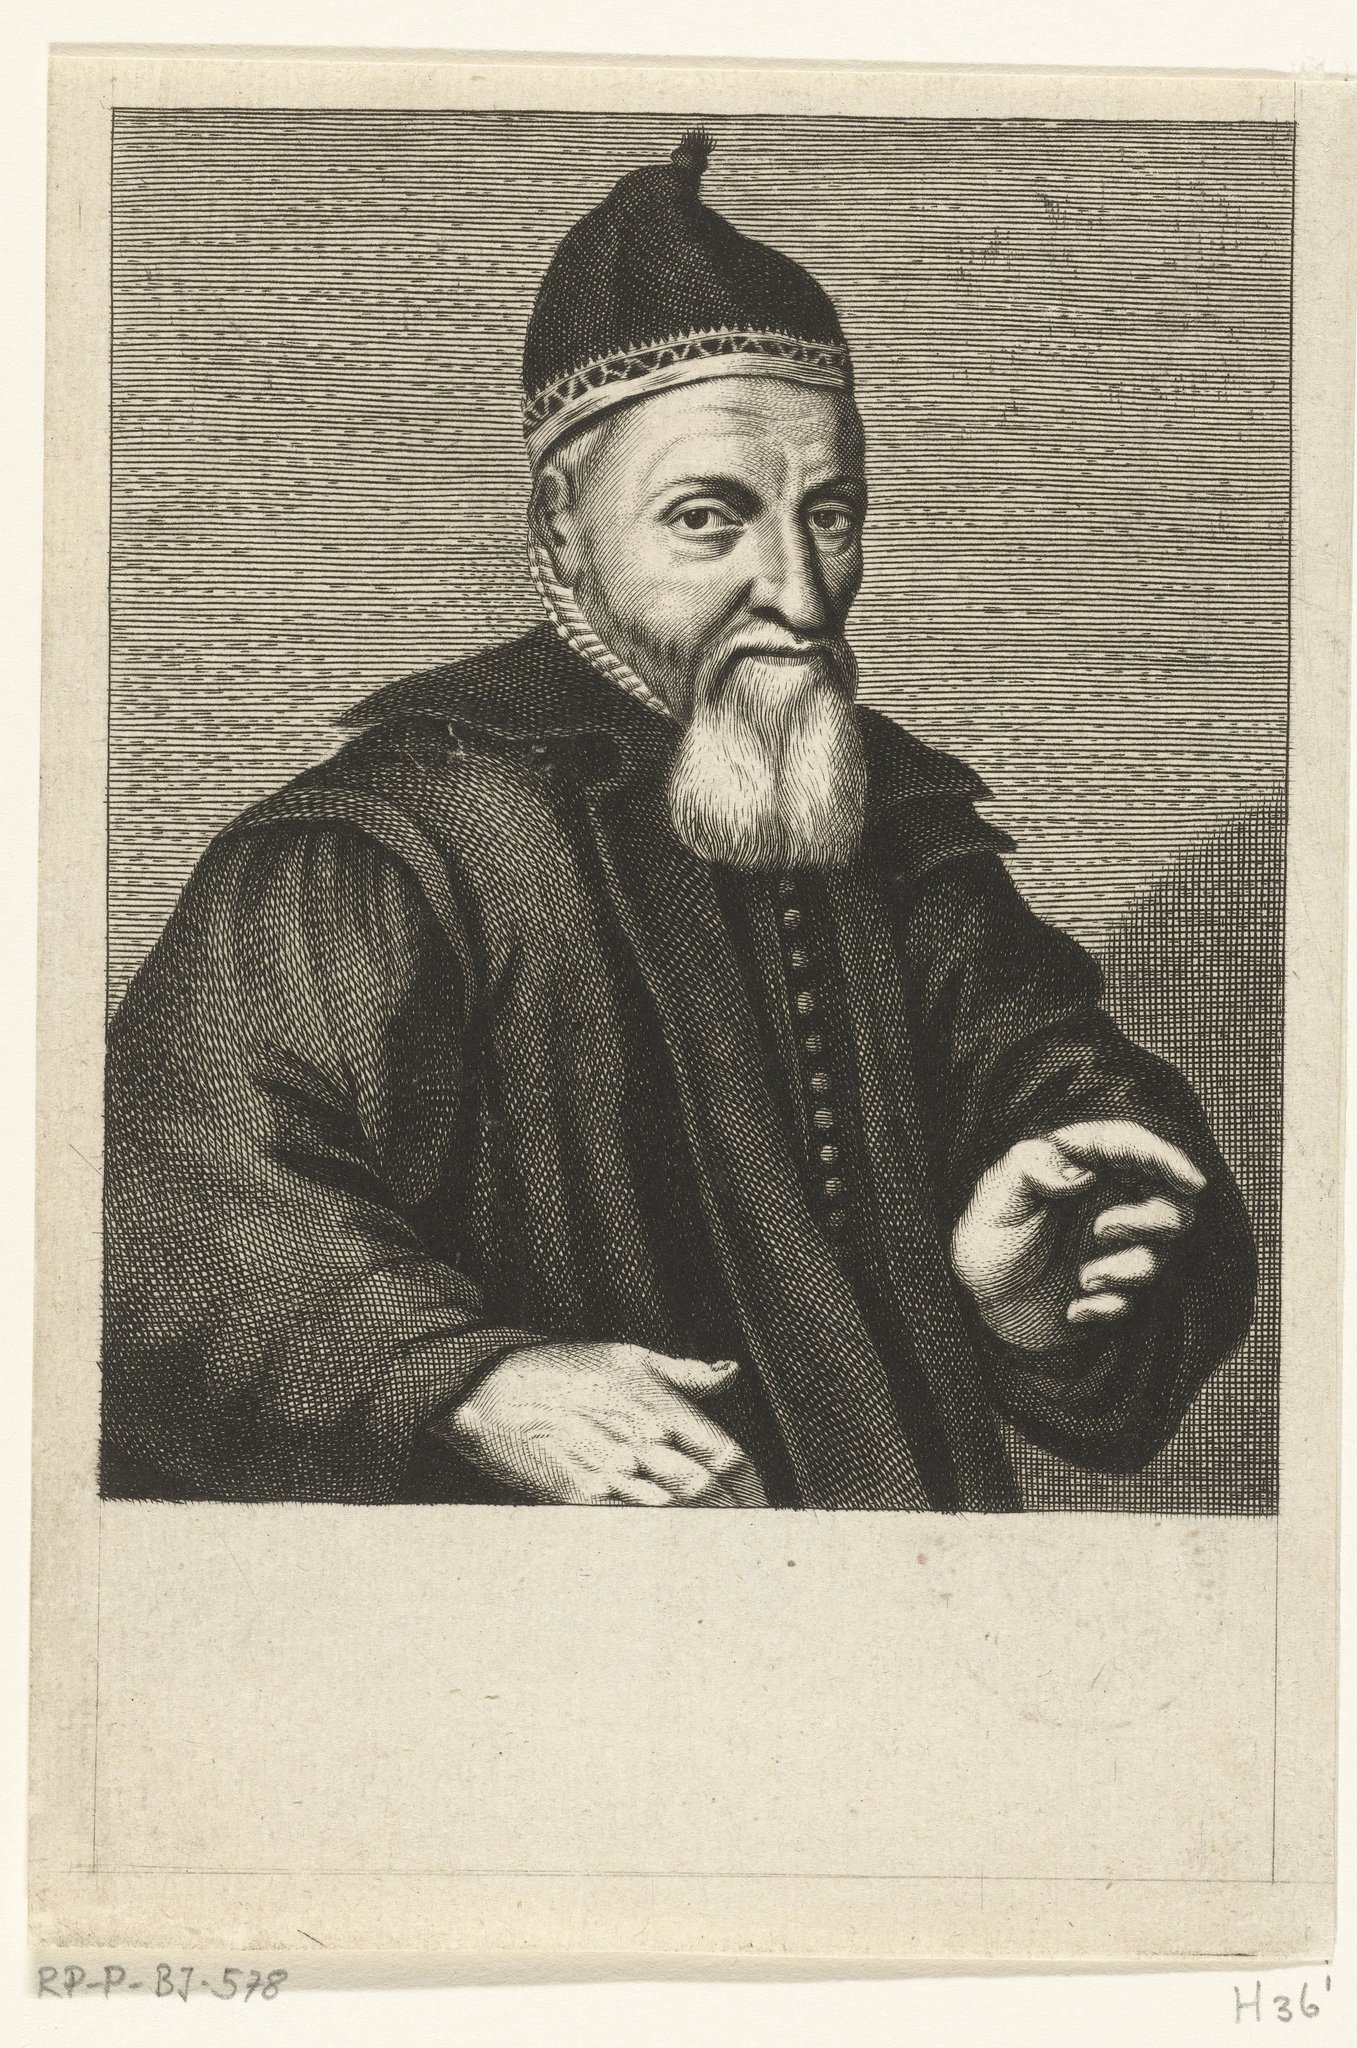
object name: print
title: Portret van Jacob Dirksz. Brouwer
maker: hendrik bary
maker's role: draughtsman, print maker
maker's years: 1640-1707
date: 1657-1707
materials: paper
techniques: engraving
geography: netherlands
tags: enkhuizen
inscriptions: collector's mark: Lugt 240